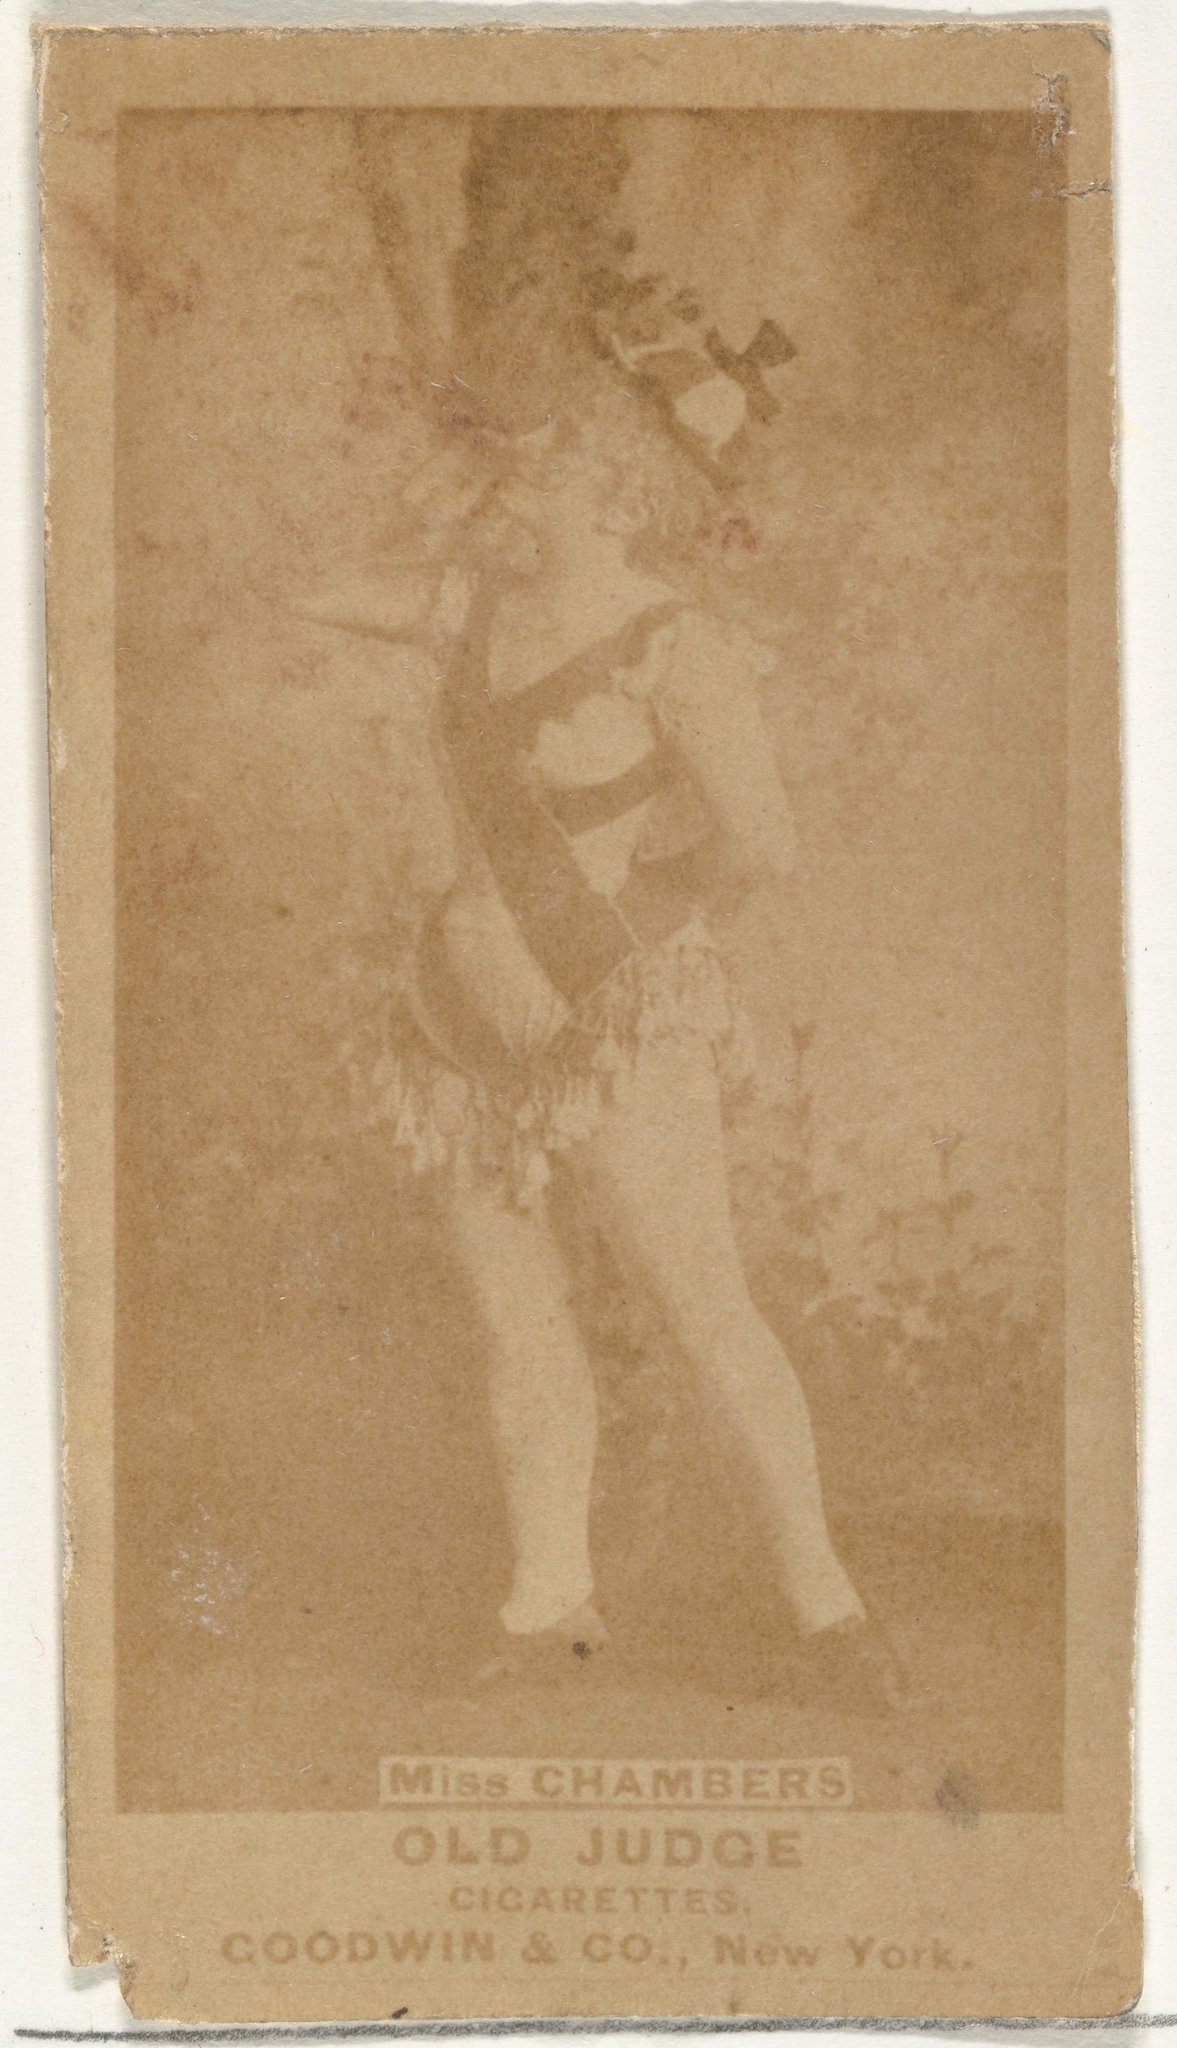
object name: photograph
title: Miss Chambers, from the Actors and Actresses series (N171) for Old Judge Cigarettes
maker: goodwin & company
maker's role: publisher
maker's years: 1850-1950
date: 1886-1890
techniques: albumen silver print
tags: portraits,women,actresses